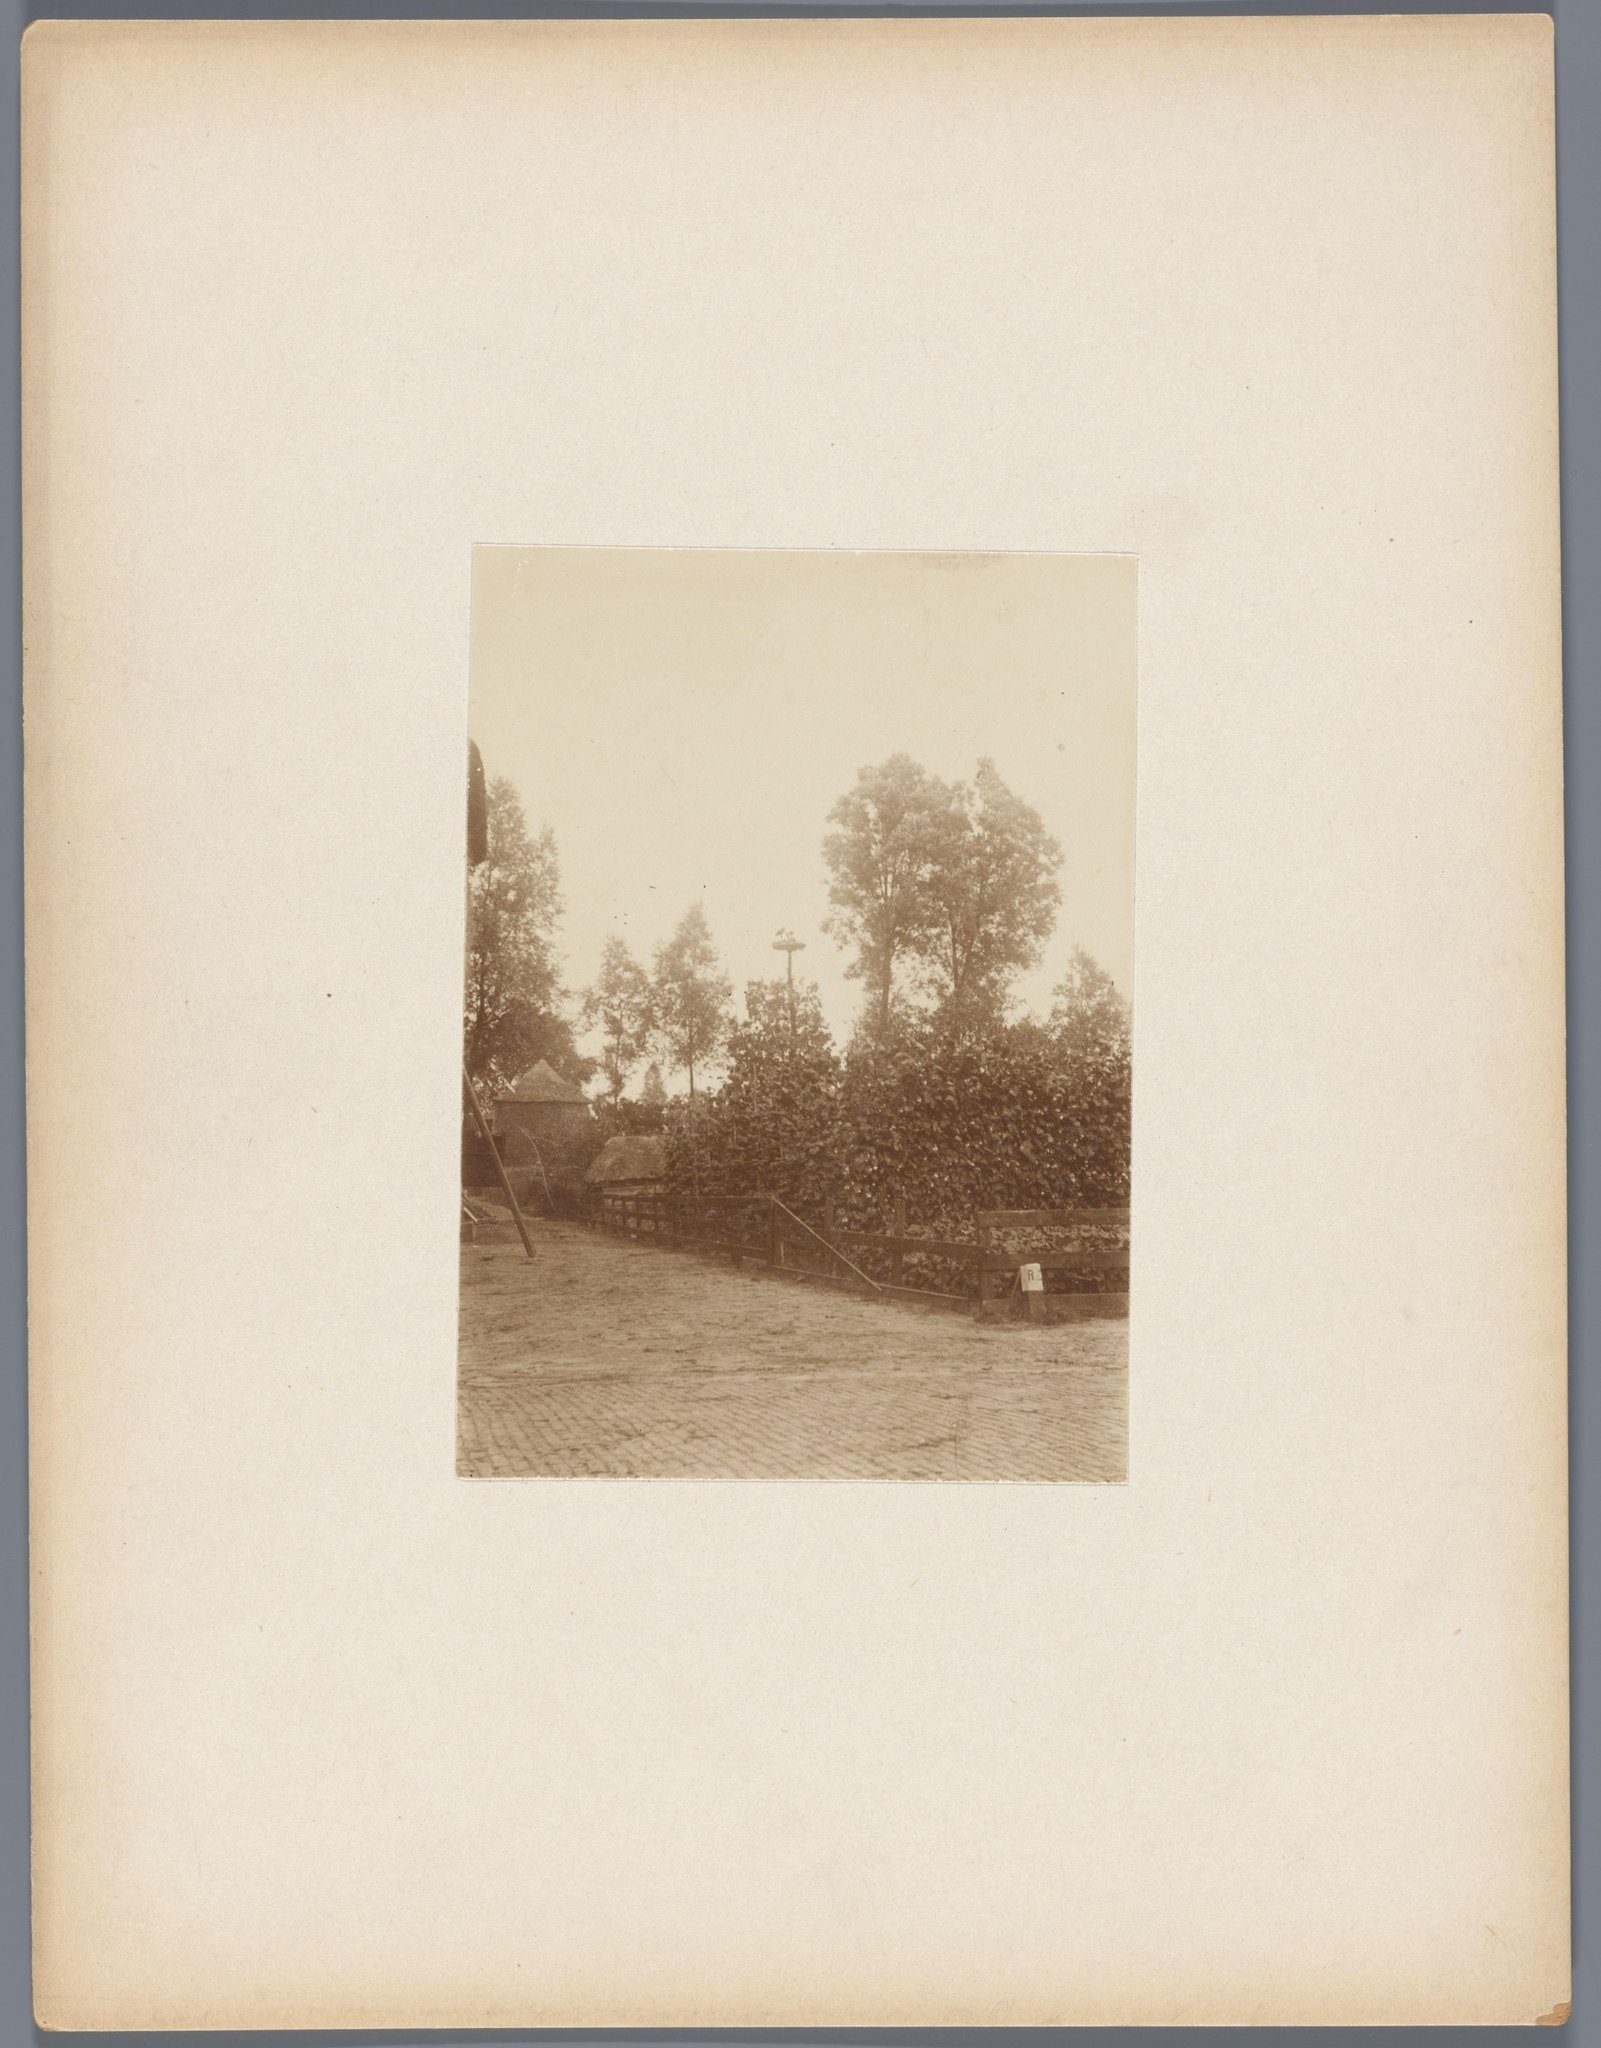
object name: photograph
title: Ooievaarsnest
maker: Anonymous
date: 1907-1910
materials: cardboard, photographic support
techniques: collodion silver print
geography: netherlands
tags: shore-birds and wading-birds: stork (+ nest, den, burrow), netherlands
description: Ooievaarsnest, tussen bomen, naast een hooischuur. Onderdeel van het losbladige fotoalbum met 39 foto's van een reis door Nederland, ca. 1907-1910.